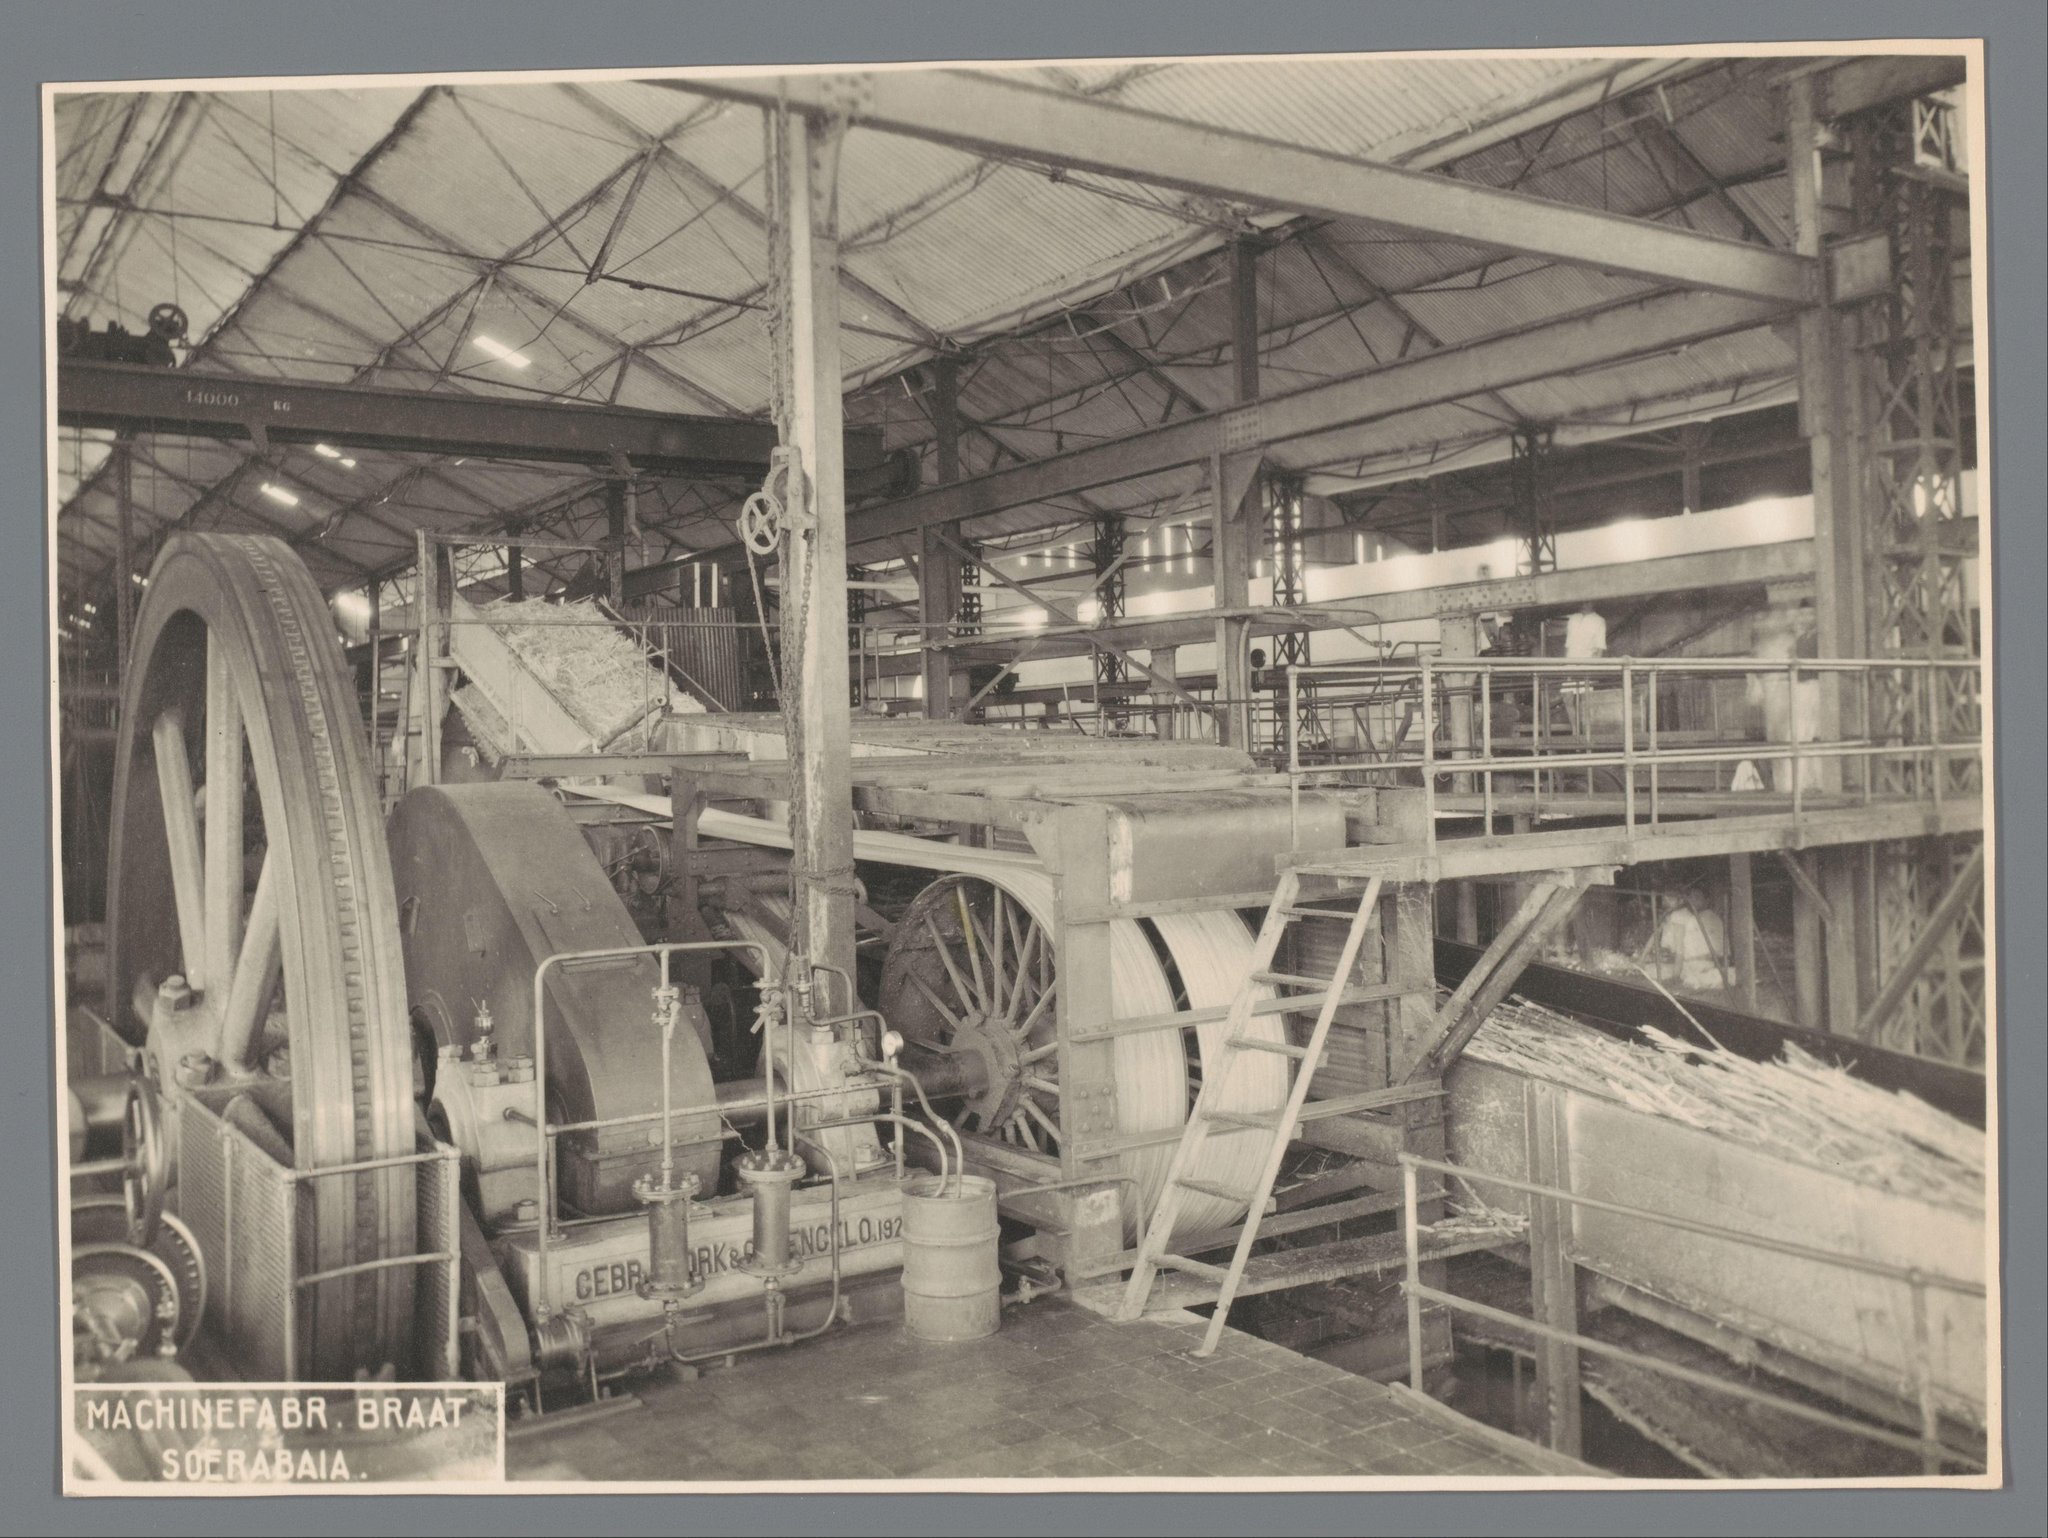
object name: photograph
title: Canecutter in bedrijf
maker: Anonymous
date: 1908-1937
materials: photographic support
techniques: gelatin silver print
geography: java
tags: colonial system, machines; parts of machines; tools and appliances, (non-fruit) products of plants or trees: sugarcane, interior of industrial structures (regardless of the materials processed or the products made, java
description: Canecutter in bedrijf op de Suikerfabriek Gempolkrep. Onderdeel van de multomap met foto's van machines van de N.V. Machinefabriek Braat te Soerabaja bestemd voor de Nederlandse suikerindustrie op Java, uit de periode 1917-1938.